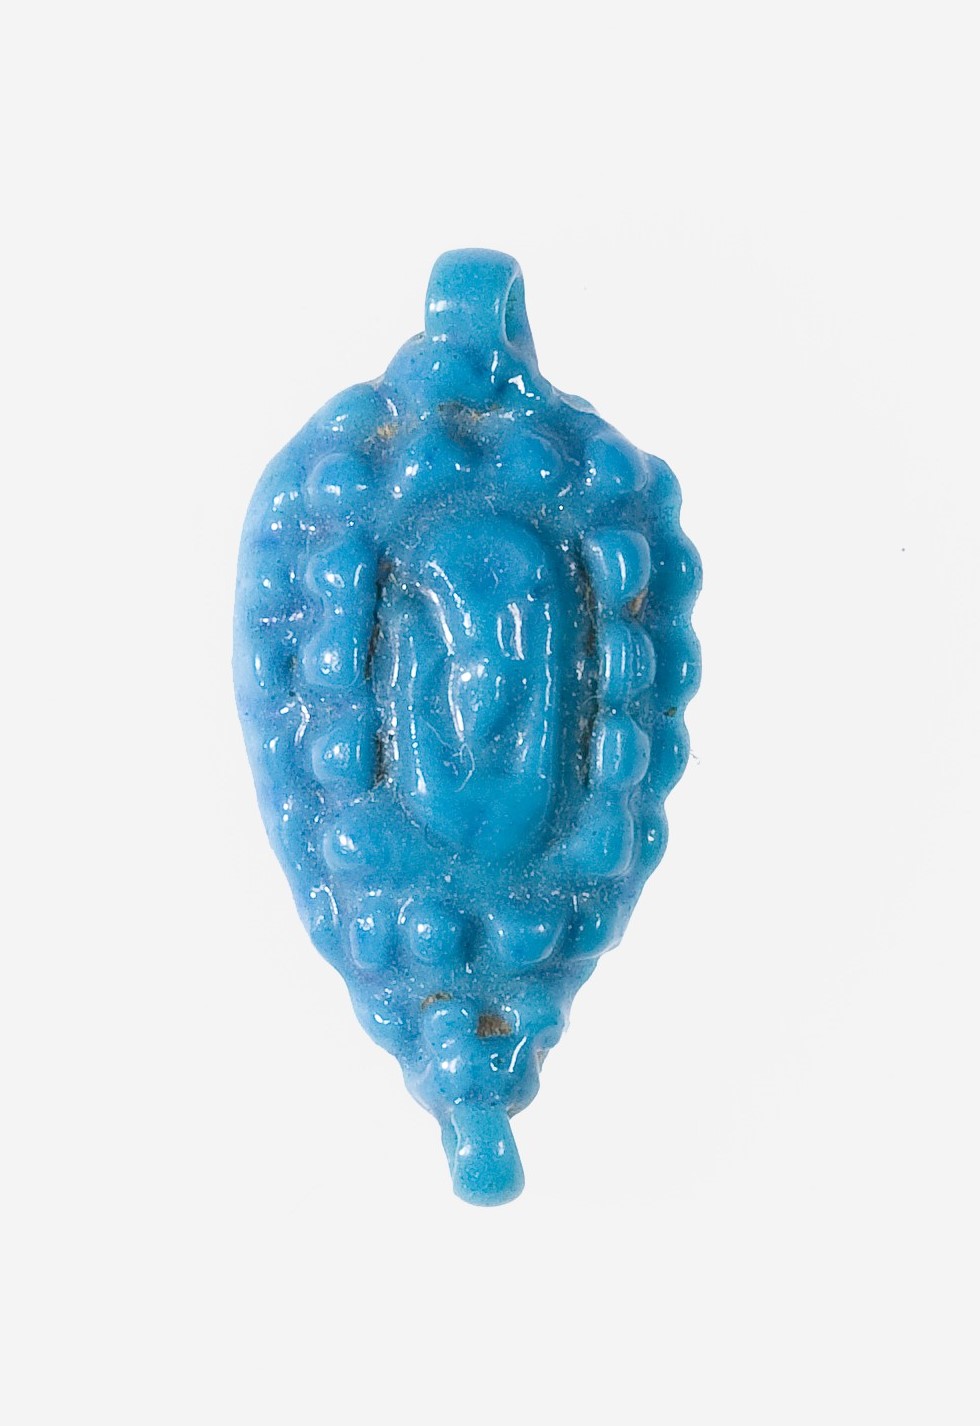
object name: bead, grape, nebmaatre cartouche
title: Bead in the Form of a Bunch of Grapes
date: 1390-1352 BCE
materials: faience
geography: egypt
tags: grapes